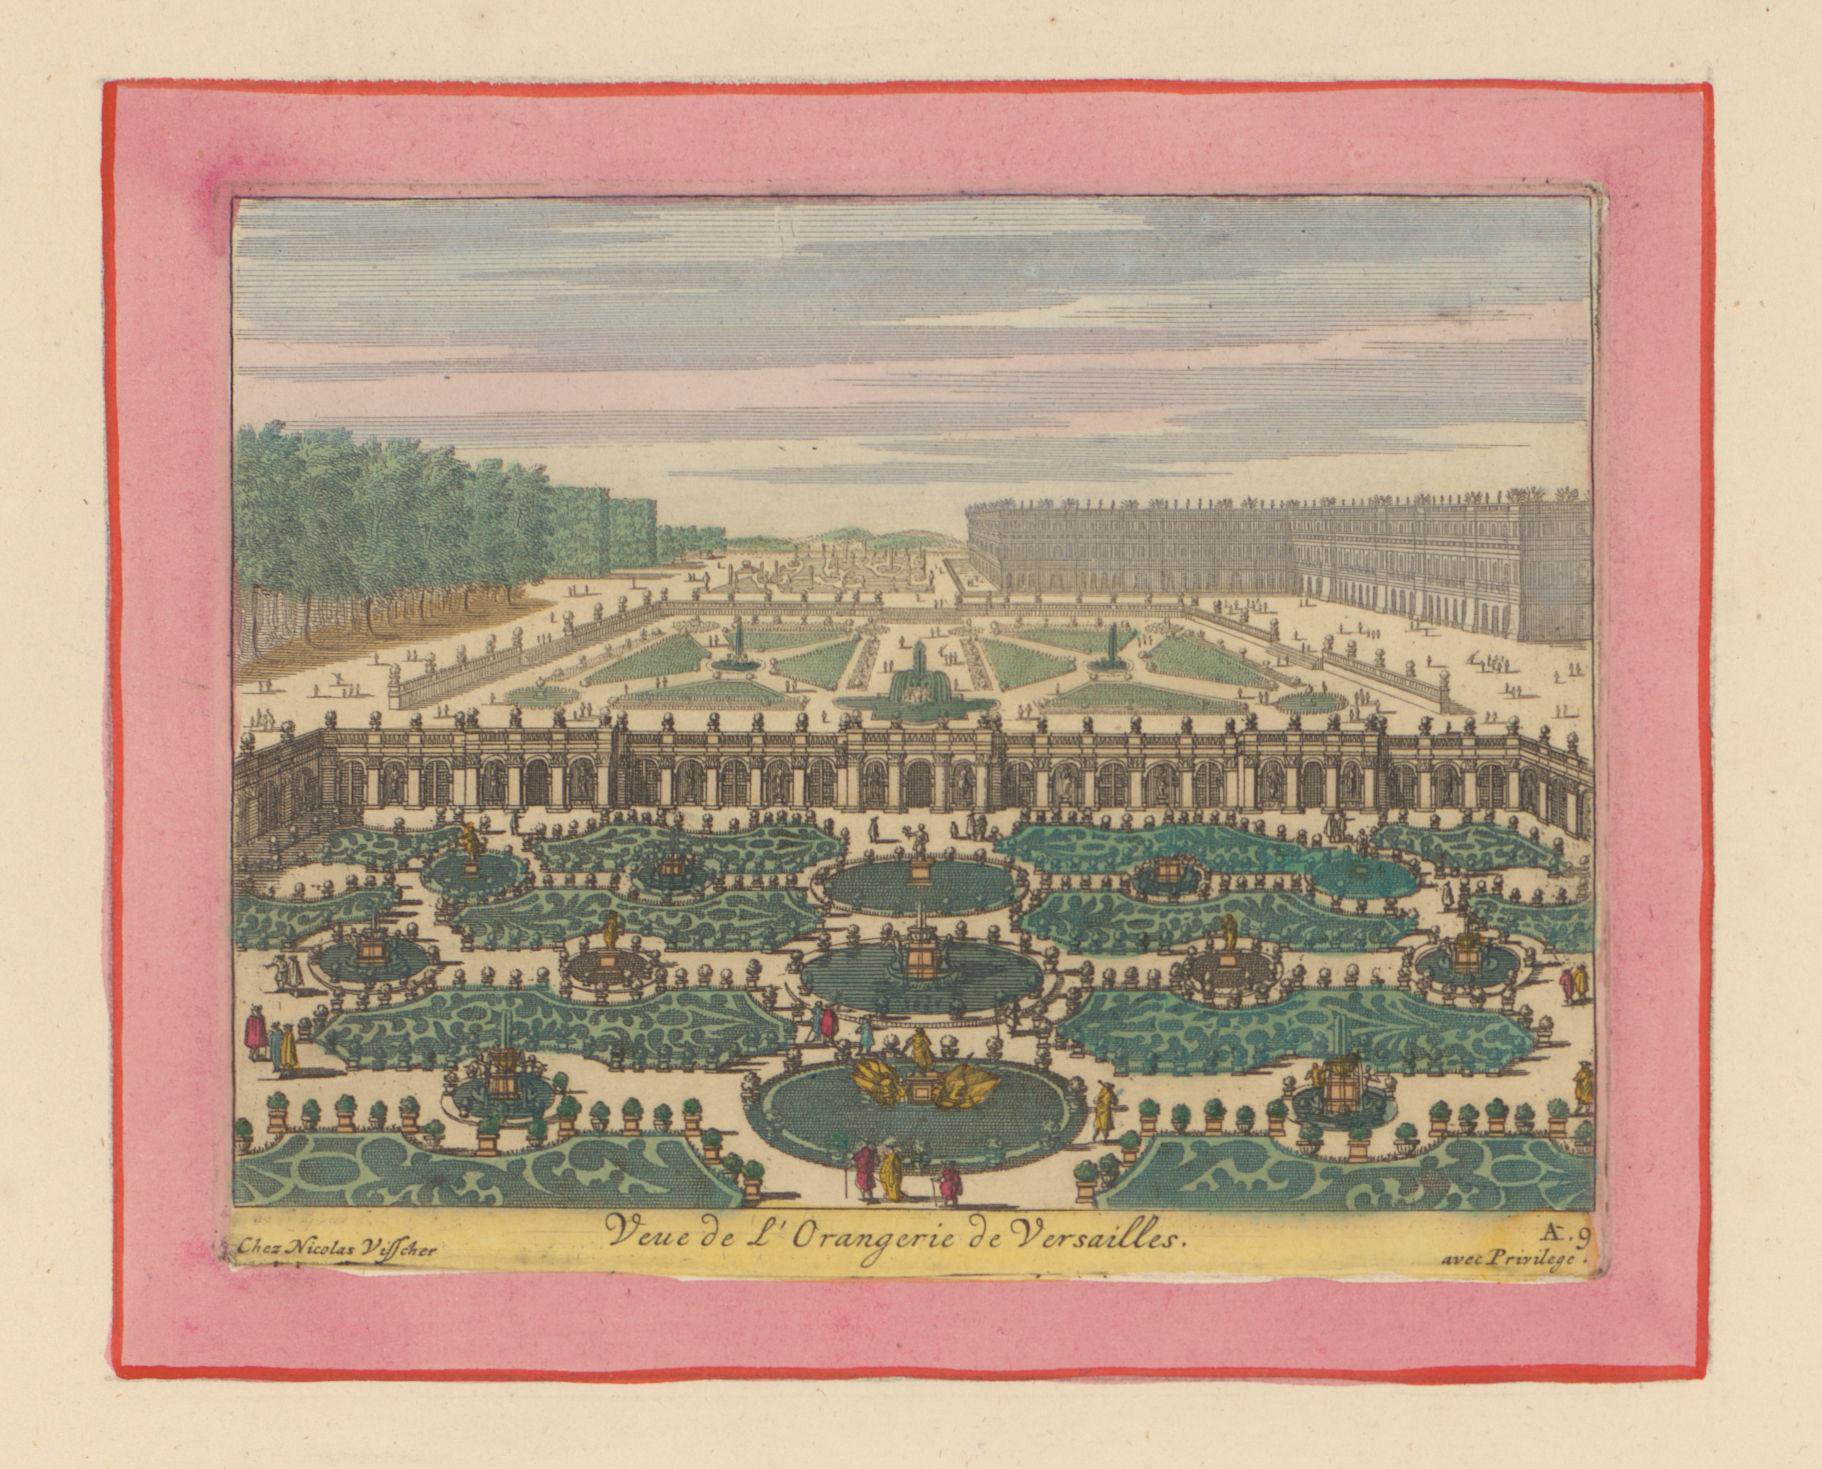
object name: print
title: Veue de l'Orangerie de Versailles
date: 1686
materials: paper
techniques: etching, hand coloring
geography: the hague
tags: french or architectonic garden; formal garden, greenhouse, orangery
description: De prent maakt deel uit van een serie bestaande uit 87 genummerde prenten (volgens Hollstein). De serie is opgedeeld in de delen A t/m F.